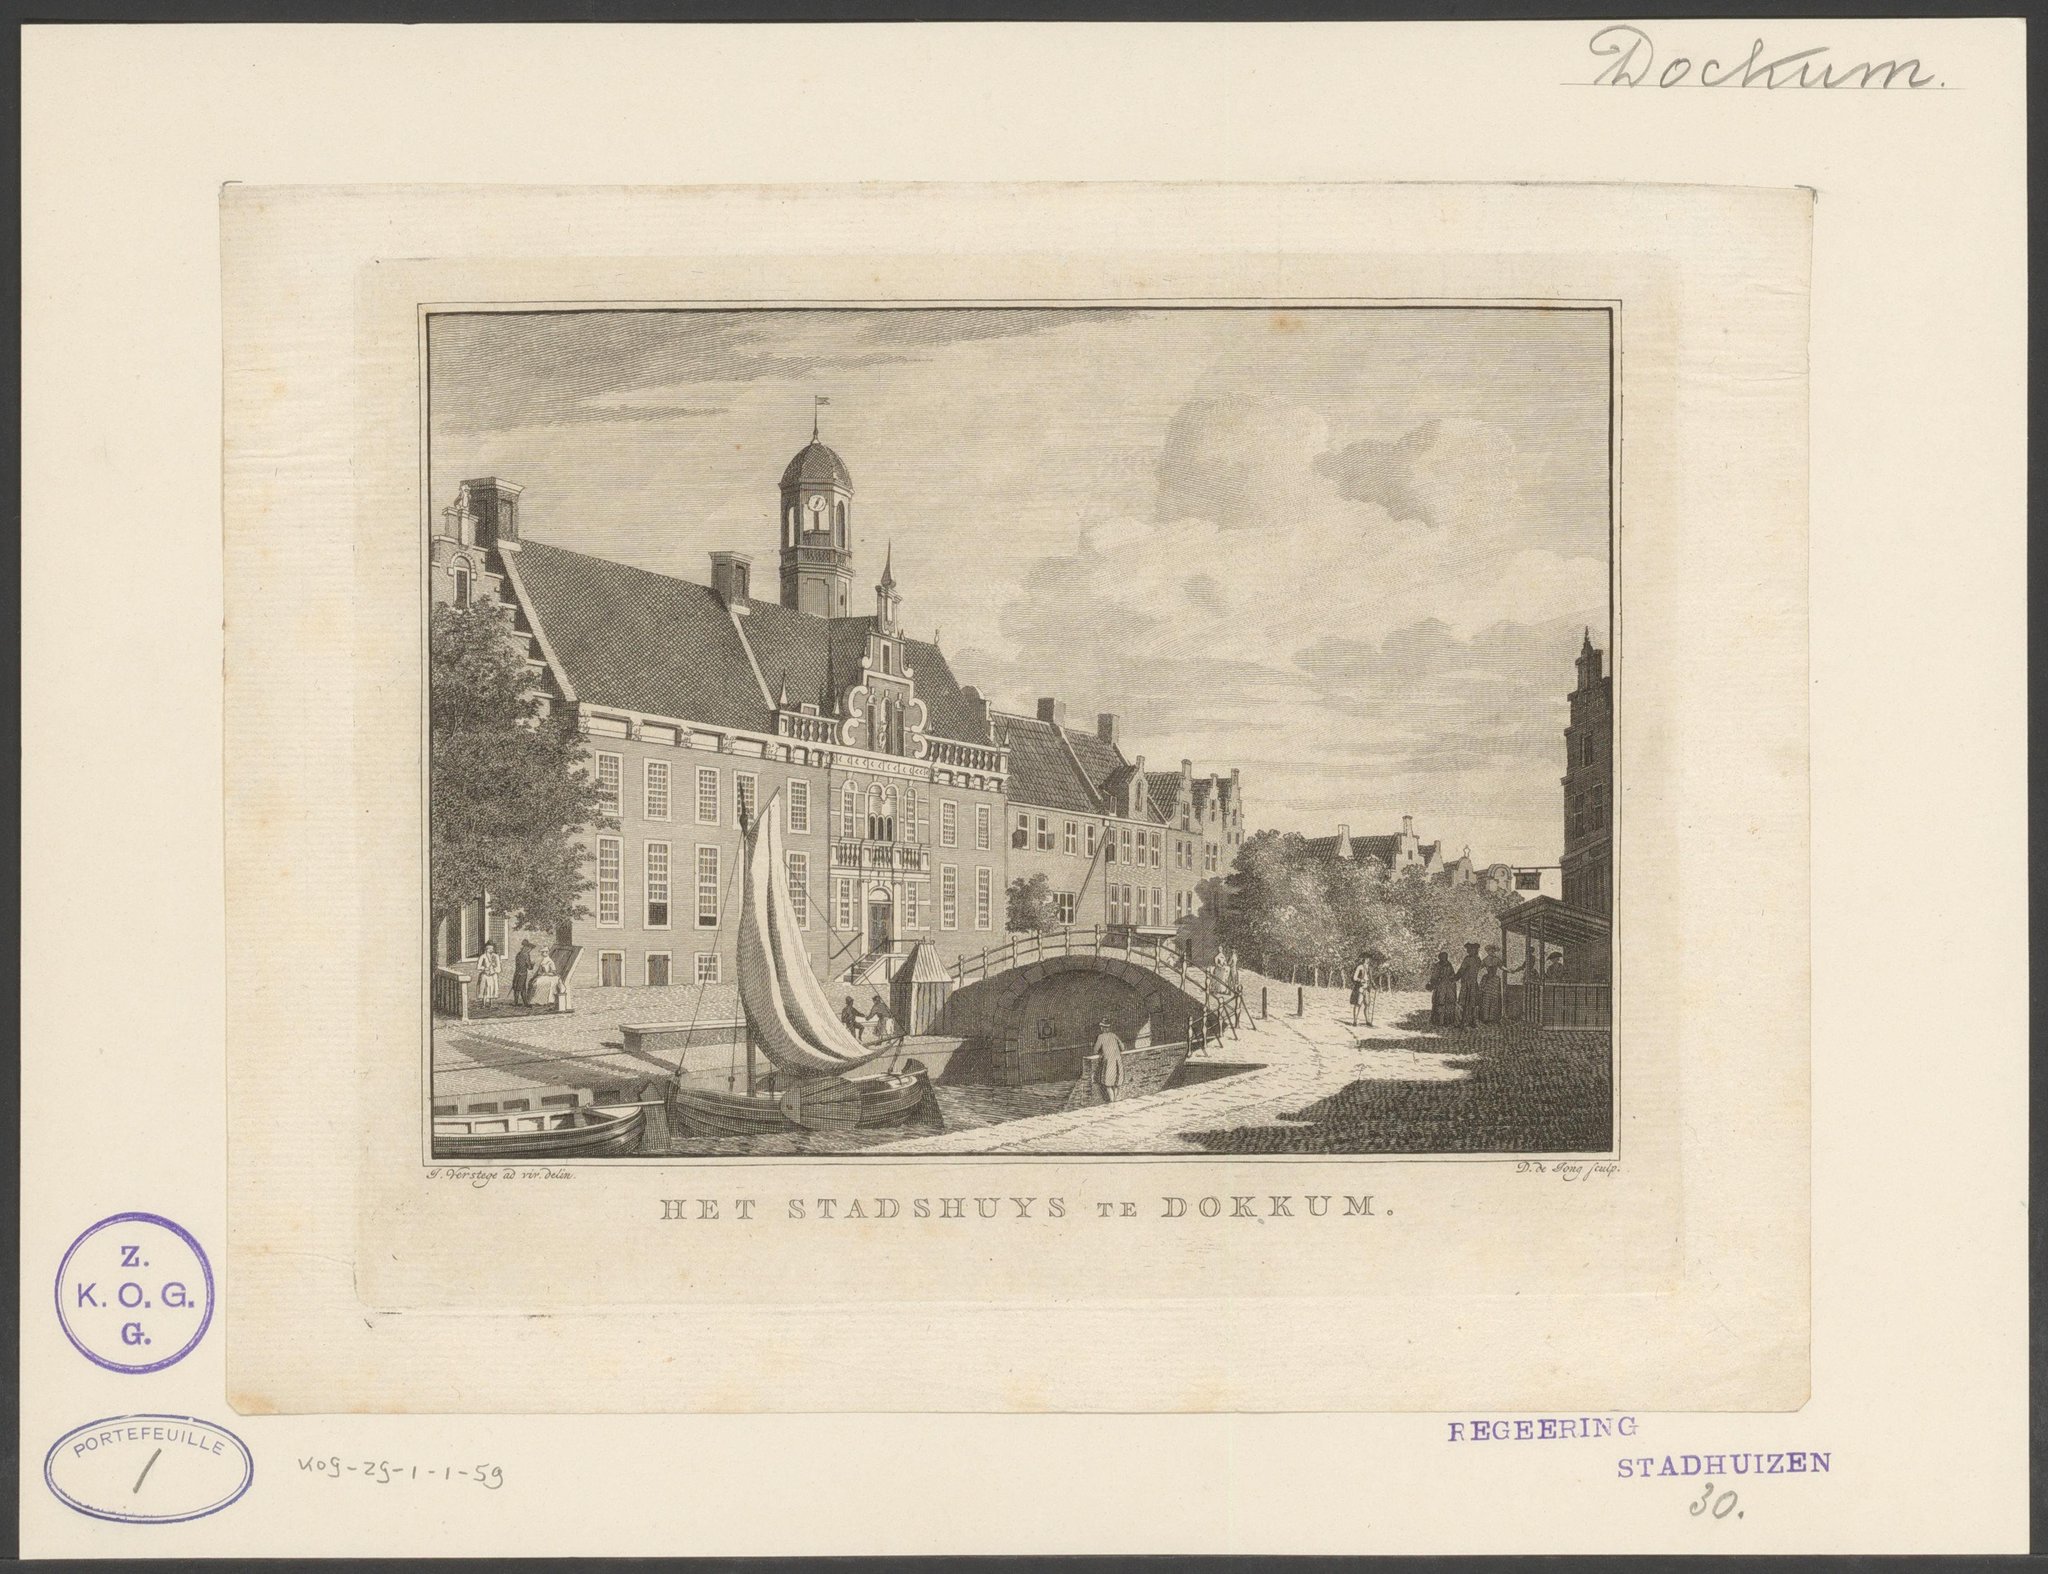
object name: print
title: Het Stadshuys te Dokkum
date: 1784-1786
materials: paper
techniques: engraving, etching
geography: northern netherlands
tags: townhall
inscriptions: collector's mark: Lugt 1641, collector's mark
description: Gezicht op het stadhuis te Dokkum. Op de voorgrond een brug en boten op het water. Onderwerpsrubrieken binnen de Atlas Zeden en Gewoonten: Regeering, Stadhuizen (B-D).